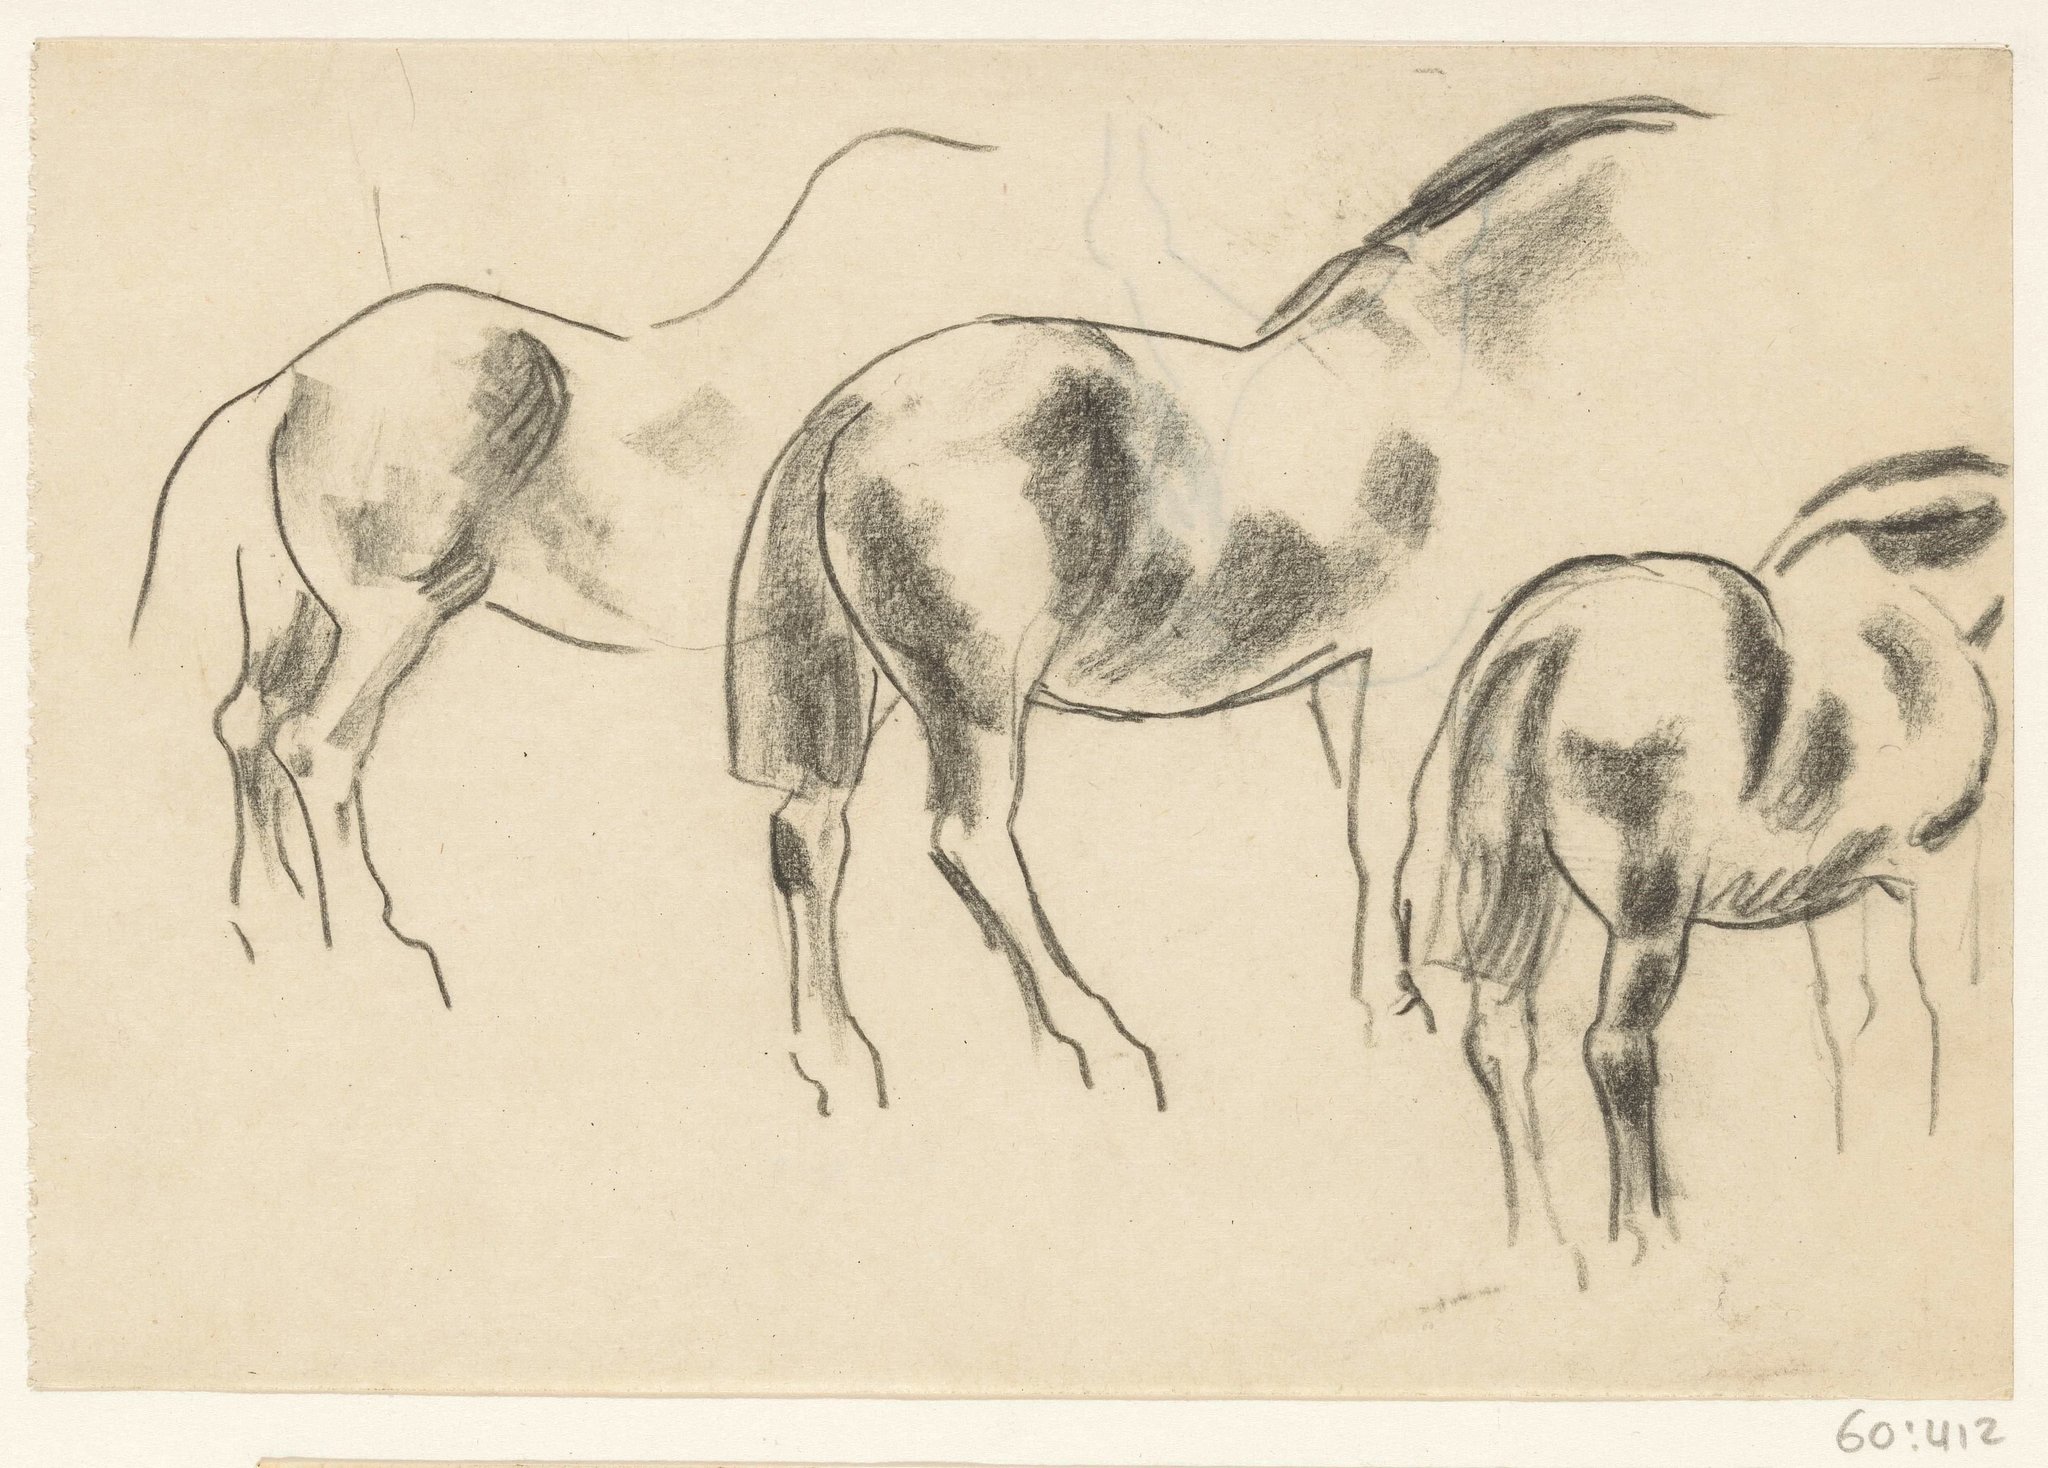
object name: drawing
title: Drie paarden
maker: leo gestel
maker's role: draughtsman, print maker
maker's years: 1881-1941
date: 1891-1941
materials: chalk, paper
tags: horse